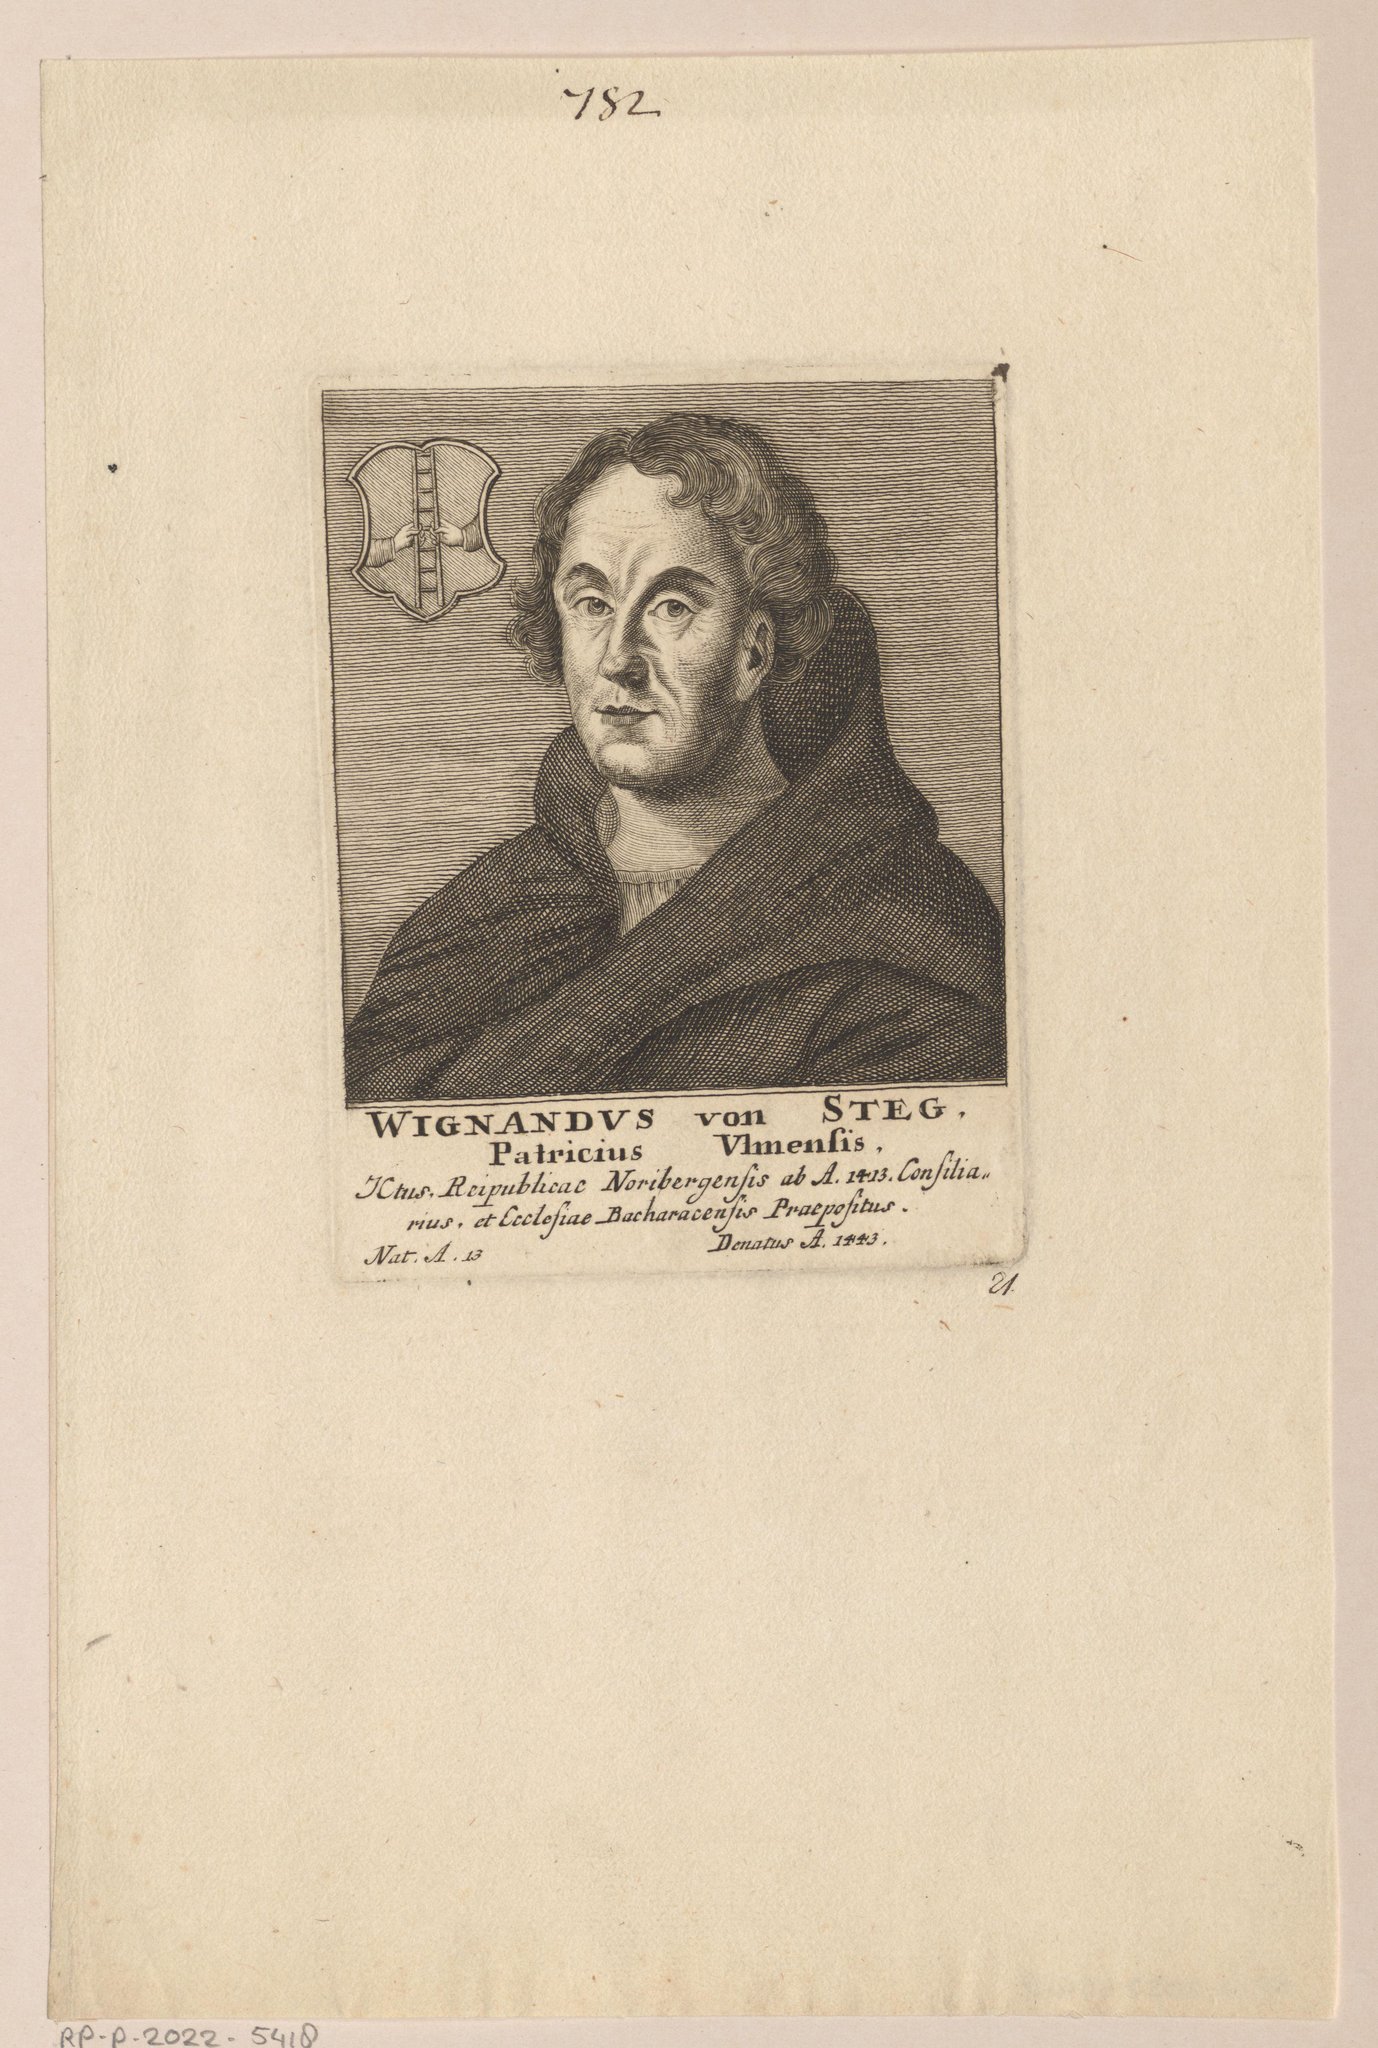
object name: print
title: Portret van Wignandus von Steg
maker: Anonymous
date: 1723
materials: paper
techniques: engraving, etching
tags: historical persons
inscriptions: number: ‘21’, number: ‘782’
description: Prent waarschijnlijk uit: Rothscholtz, Friedrich. Icones consiliariorum de illustri republica Noribergensi (...). Neurenberg en Altdorf: erven Johann Daniel Tauber, 1723.